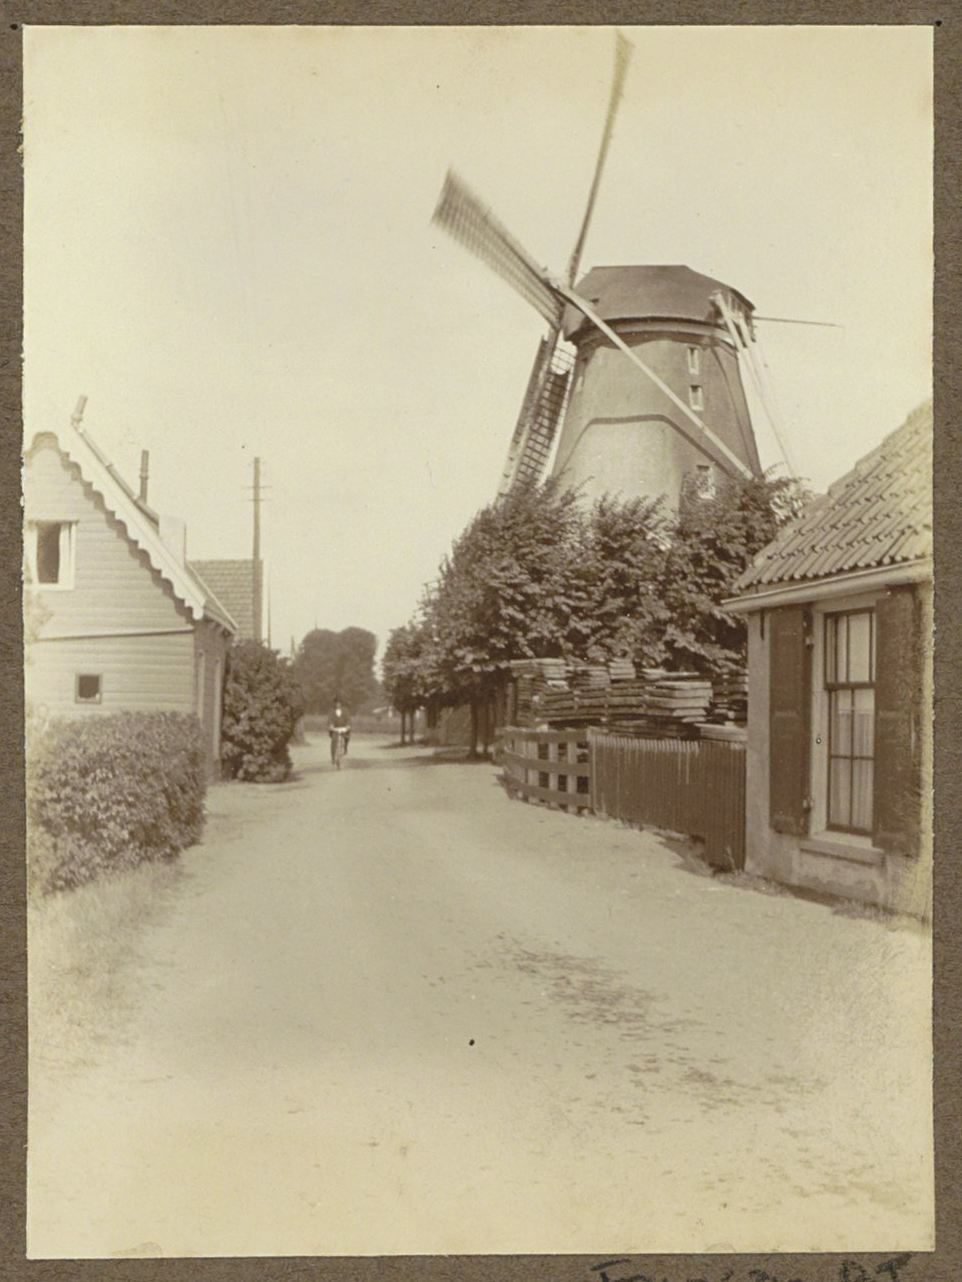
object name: photograph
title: Dorpsstraat met fietser en windmolen bij Weesp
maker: Anonymous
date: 1910-1930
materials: paper, photographic support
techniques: daylight paper print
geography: weesp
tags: village street, windmill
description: Onderdeel van Album met foto's van Amsterdam en omgeving.